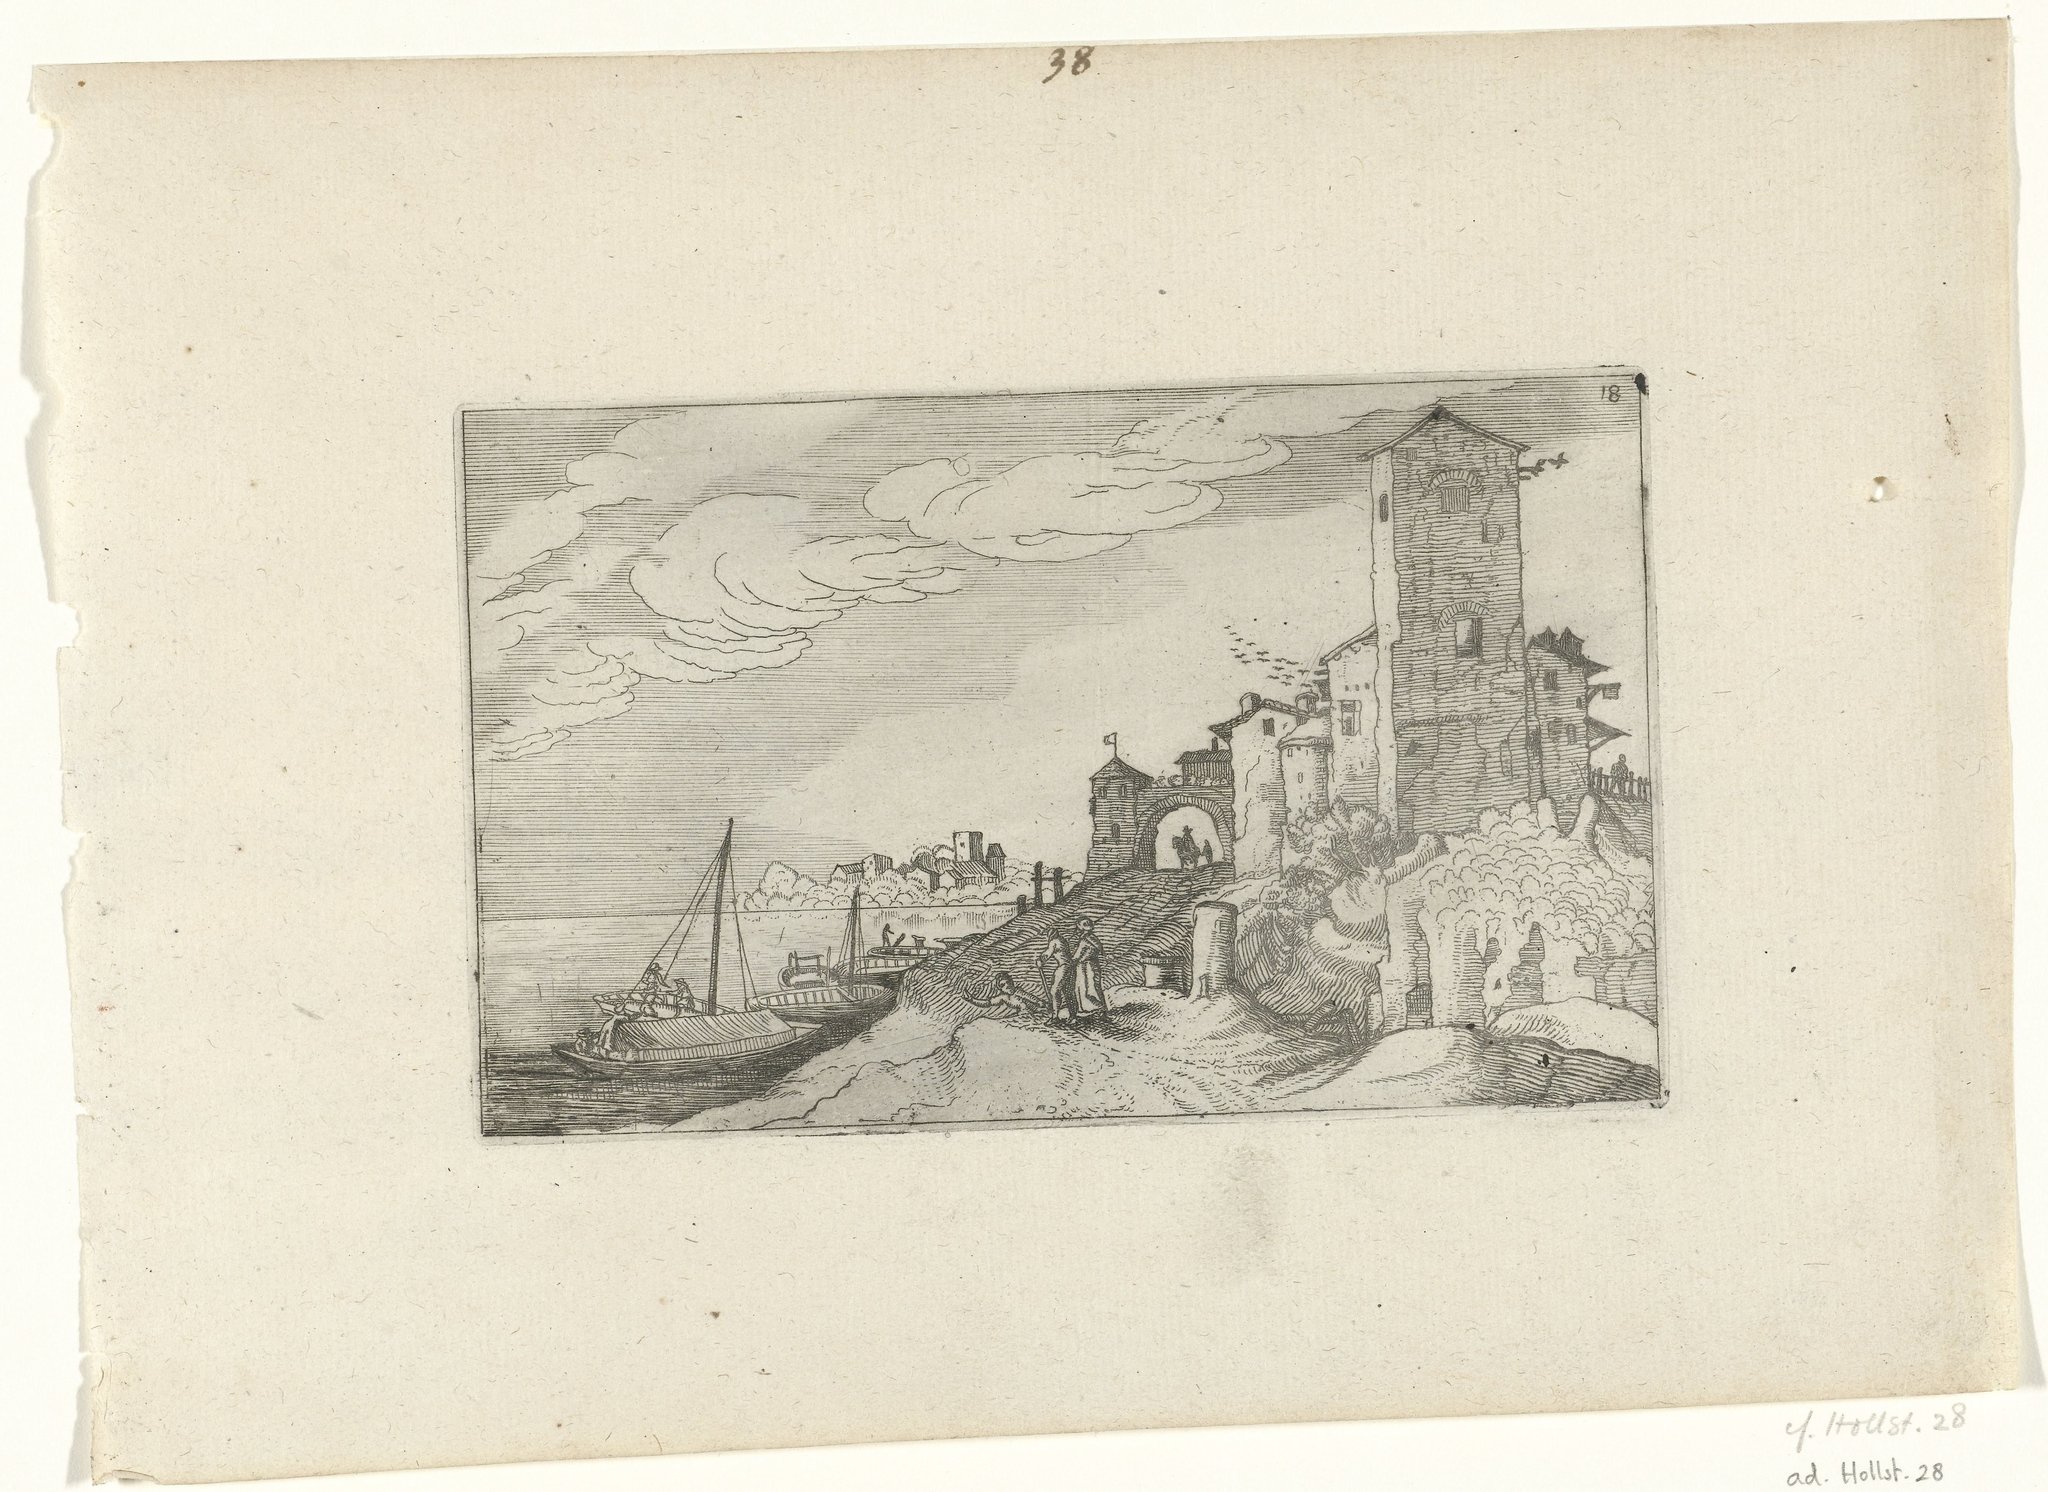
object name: print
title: Toren en poort aan de kust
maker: Anonymous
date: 1594-1685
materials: paper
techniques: etching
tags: landscape with tower or castle, coast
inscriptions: collector's mark: Lugt 2760, inscription: ‘38’, collector's mark: Lugt 2228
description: Rechts een aantal gebouwen en een toren aan de kust. Langs het water loopt een weg onder een poort door. Links in het water enkele bootjes. Prent maakt deel uit van een serie Romeinse ruïnes en kustlandschappen naar prenten van Willem van Nieulandt. Deze serie is een kopie van de serie, die Claes Jansz Visscher naar Van Nieulandt maakte.